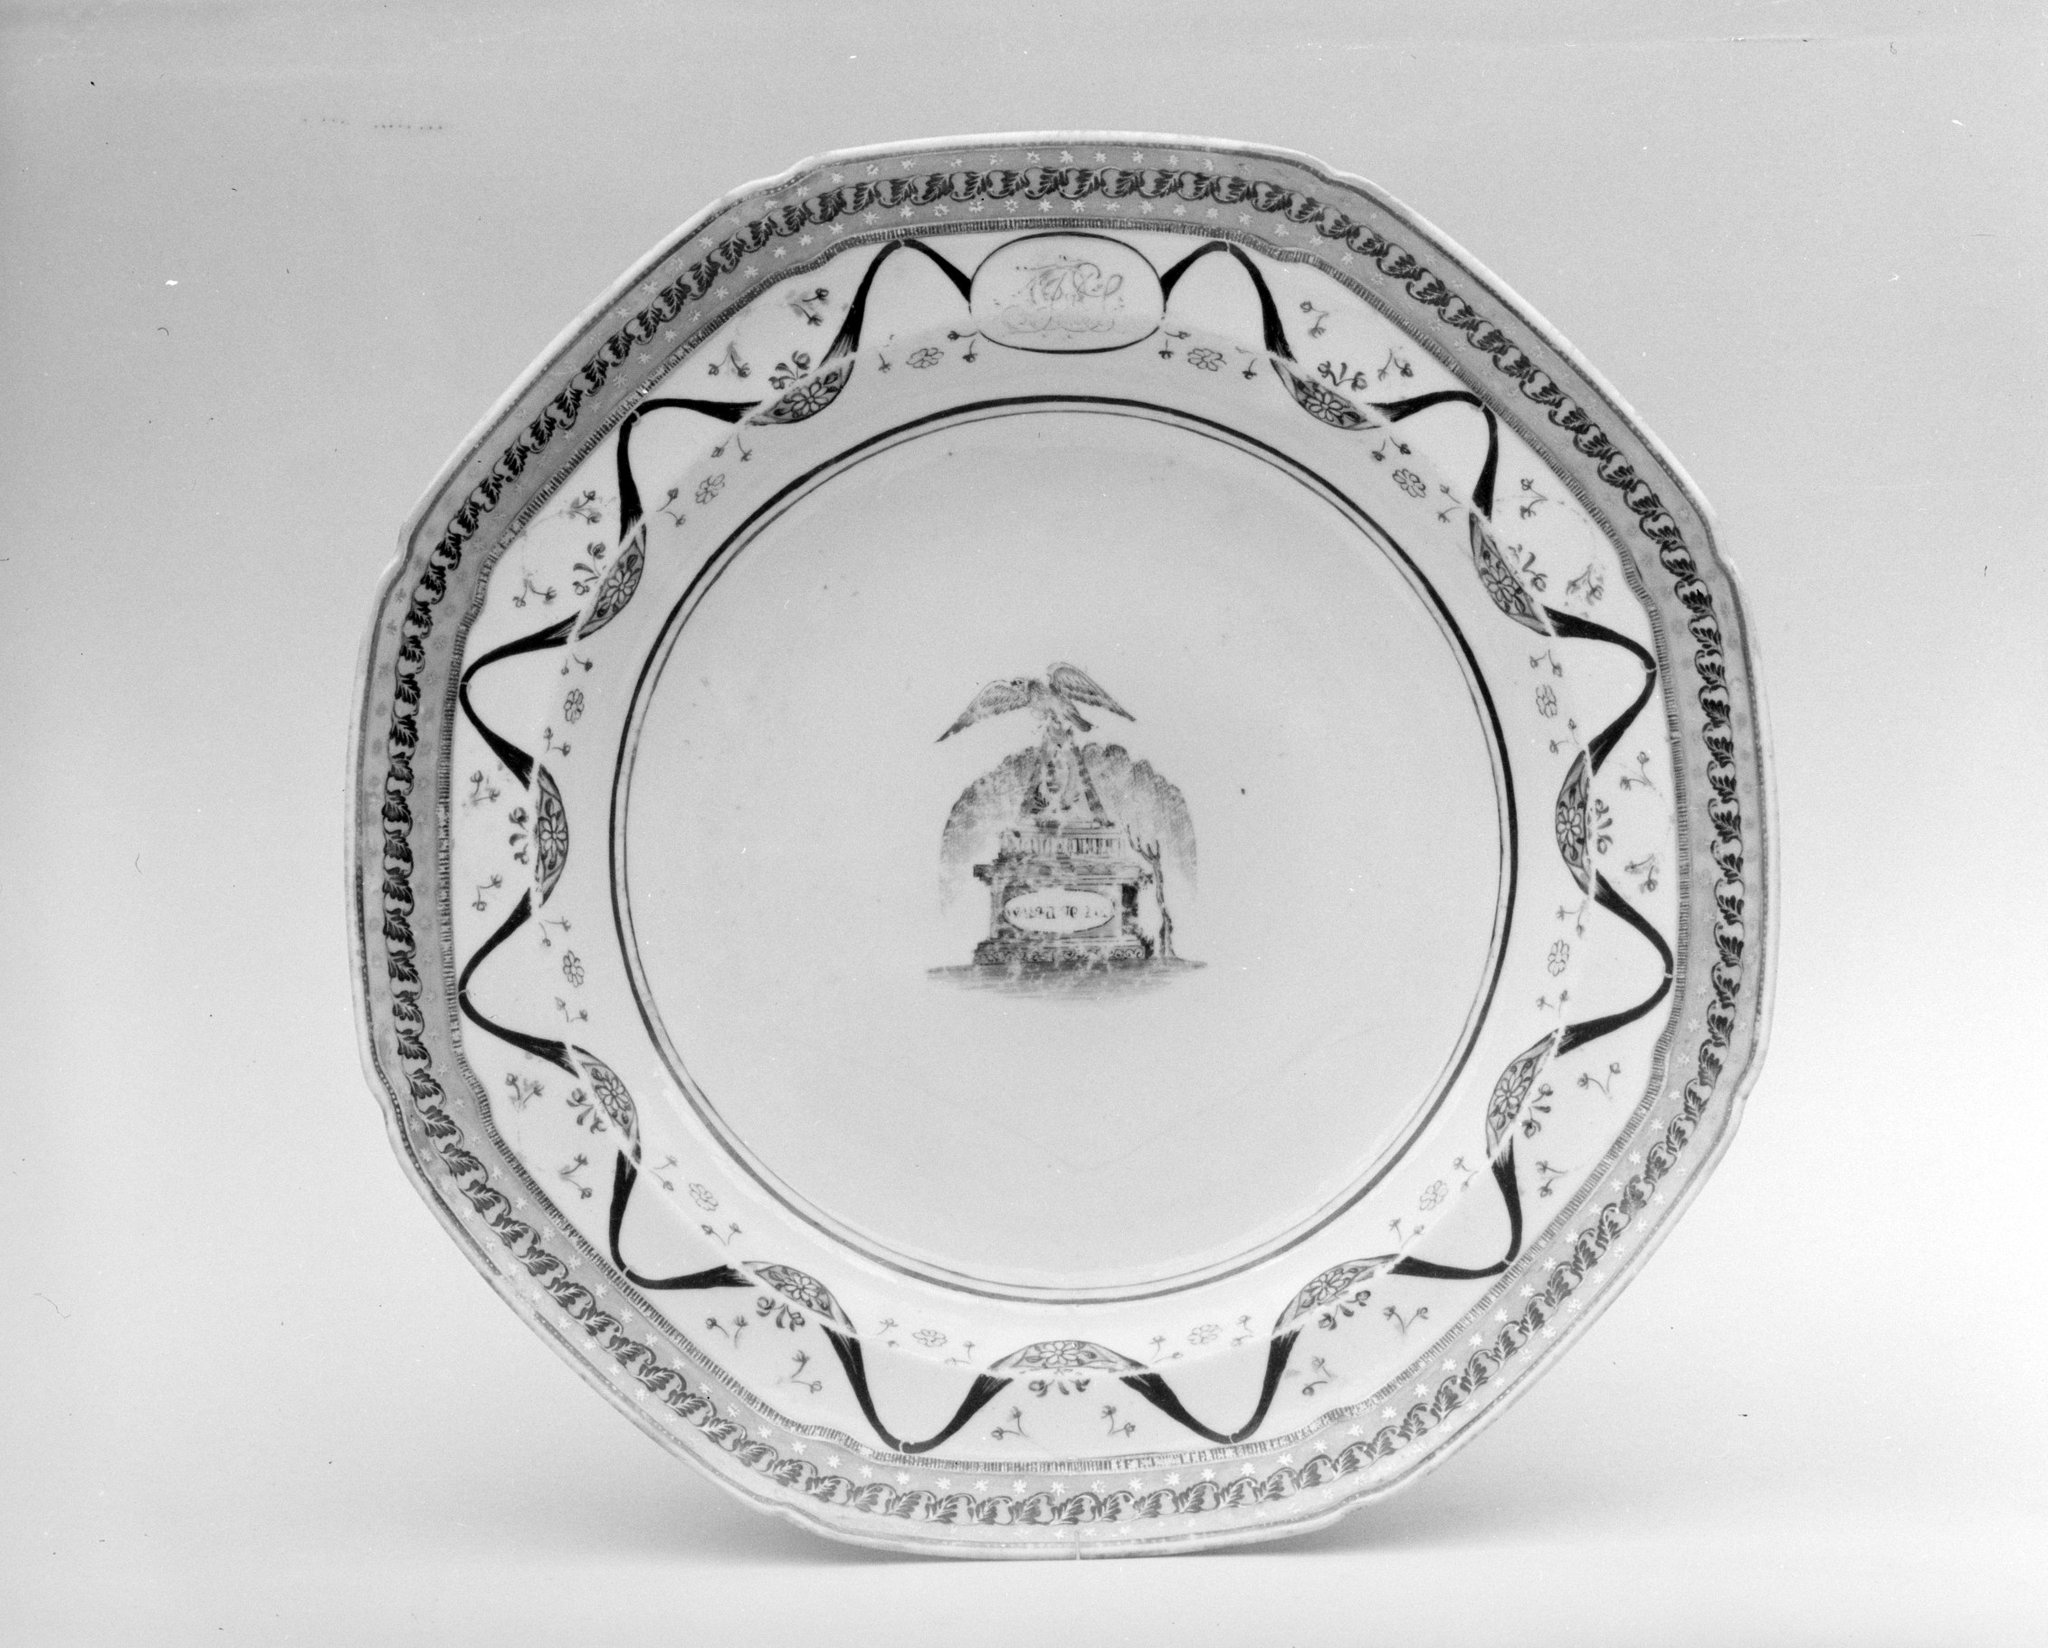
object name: plate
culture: chinese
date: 1800-1810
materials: porcelain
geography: china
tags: eagles